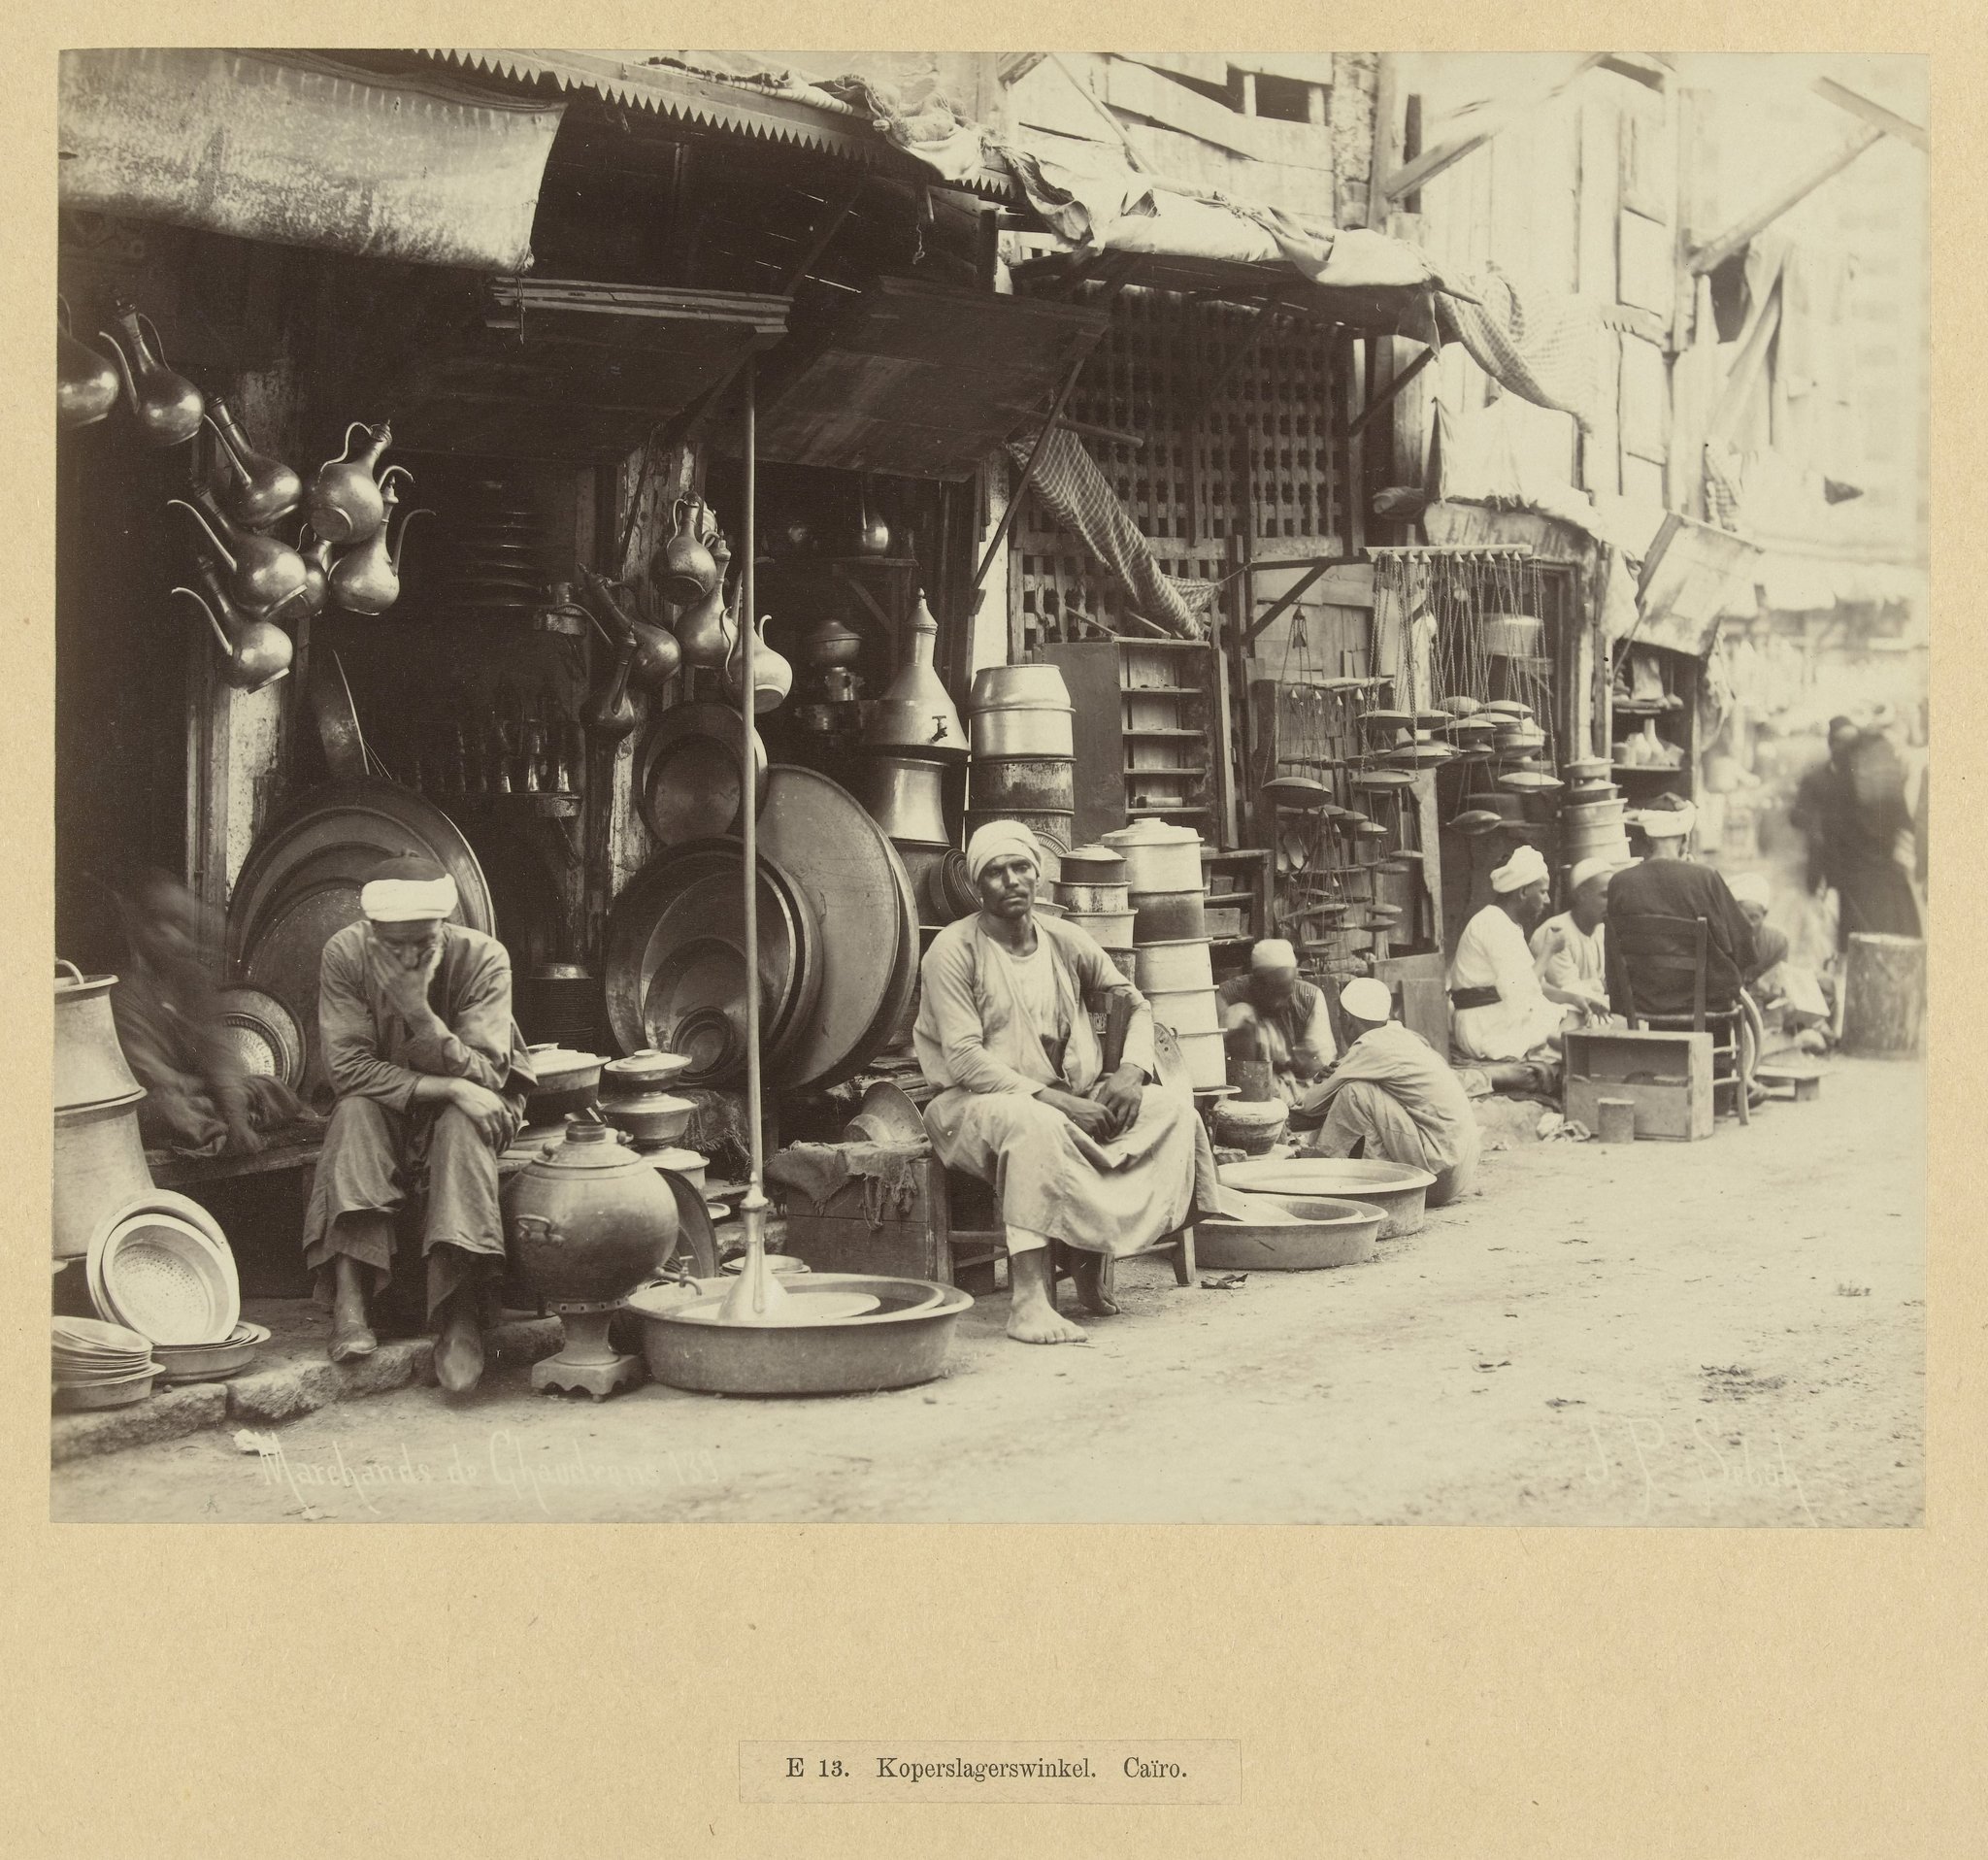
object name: photograph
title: E 13. Koperslagerswinkel. Caïro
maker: jean pascal sébah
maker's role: fotograaf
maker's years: 1872-1947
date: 1888-1895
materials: cardboard, paper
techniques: albumen print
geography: cairo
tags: shop, store, container of metal: bucket, can, canister, drum, tin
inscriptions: stamp: ‘Gemeentelijke bibliotheek/ Rotterdam’, number: ‘139’, check stamp: ‘Bristol/ L.M.’, title: ‘E 13. Koperslagerswinkel. Caïro.’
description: Onderdeel van een groep door fotograaf Richard Polak op reis verzamelde foto’s. Deze foto is samen met andere op zijn reizen verzamelde foto's tentoongesteld bij de Rotterdamsche Kunstkring (1895), Arti en Amicitiae te Amsterdam (1897-1898?) en Societeit 't Collegie te Kampen (datum vooralsnog onbekend).